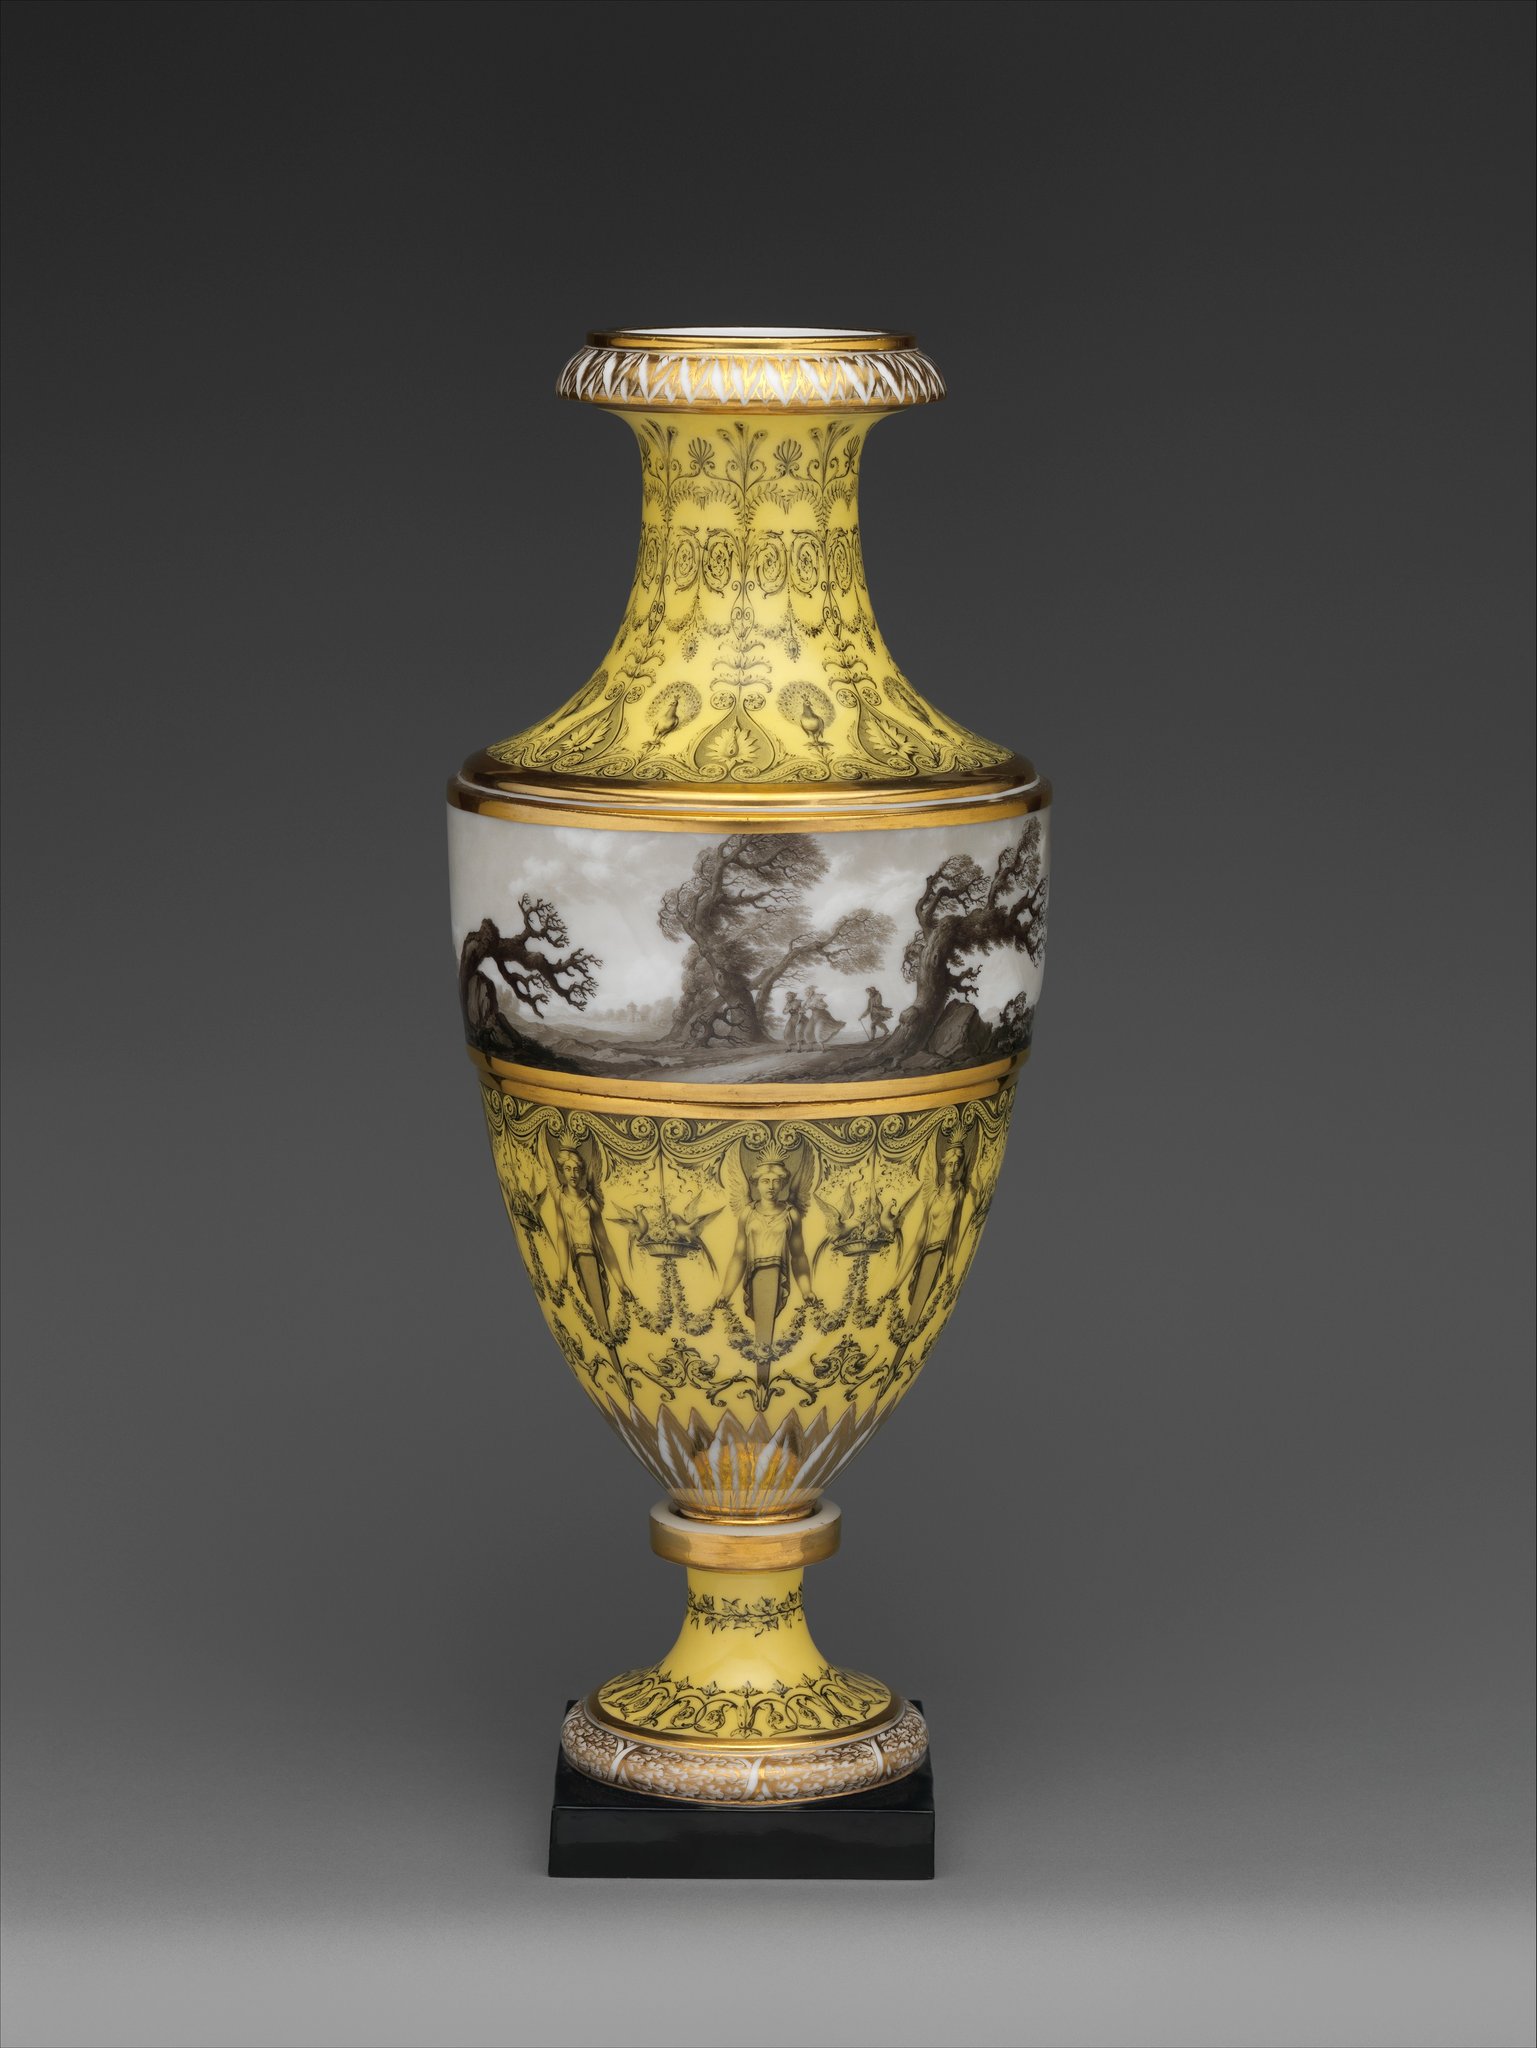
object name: vase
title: Vase with scenes of storm on land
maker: dihl et guérhard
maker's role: manufacturer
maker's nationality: french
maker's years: 1781-1824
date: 1797-1798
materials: enamel, gold, hard paste porcelain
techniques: polychrome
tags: landscapes,trees,storms